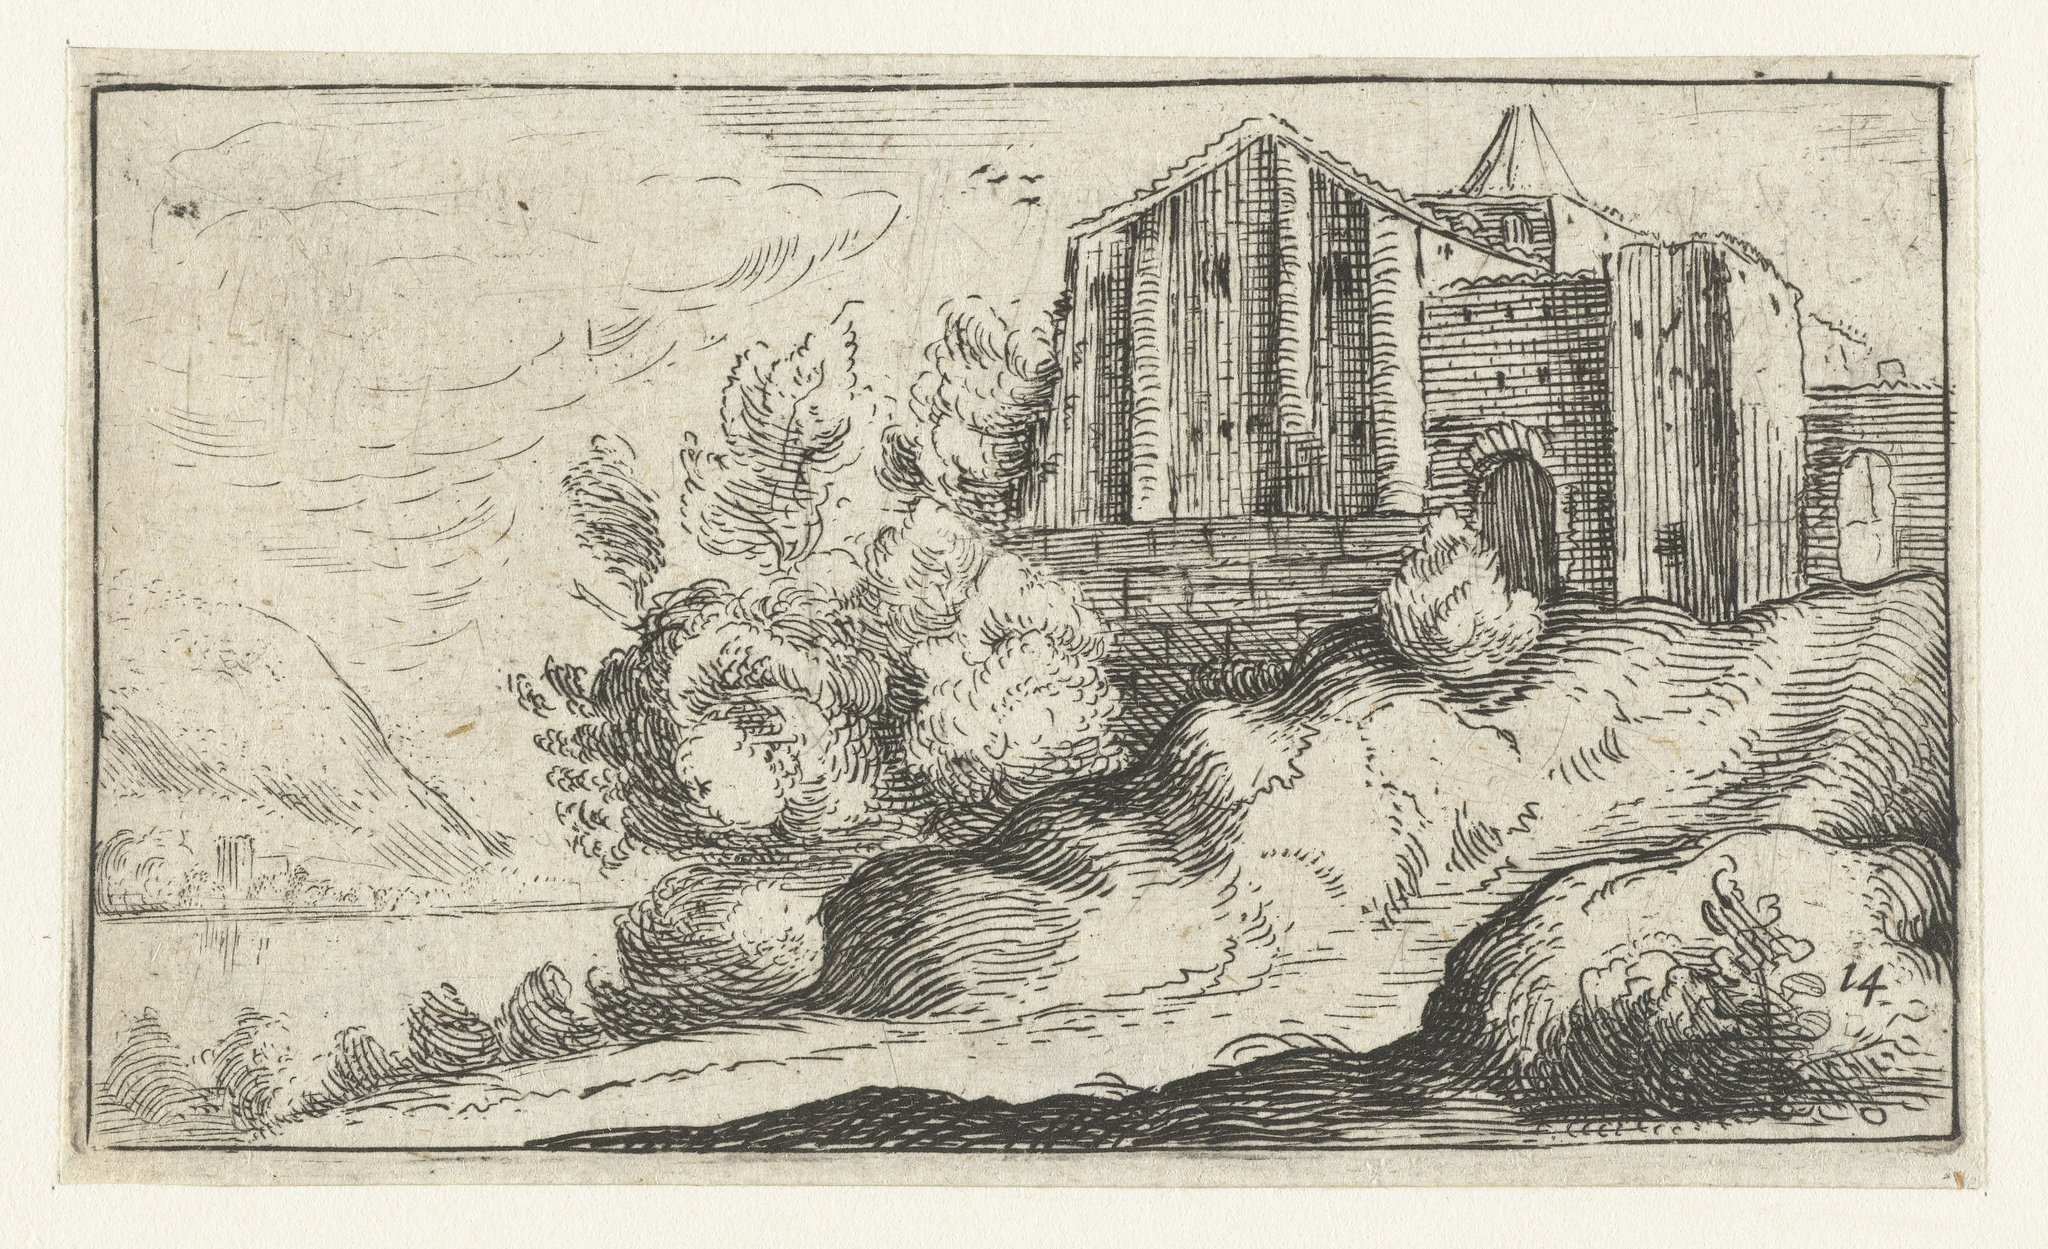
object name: print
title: Gebouwen op een rots bij een rivier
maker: Anonymous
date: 1600-1699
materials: paper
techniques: engraving, etching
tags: river, rocks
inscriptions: collector's mark: Lugt 2227